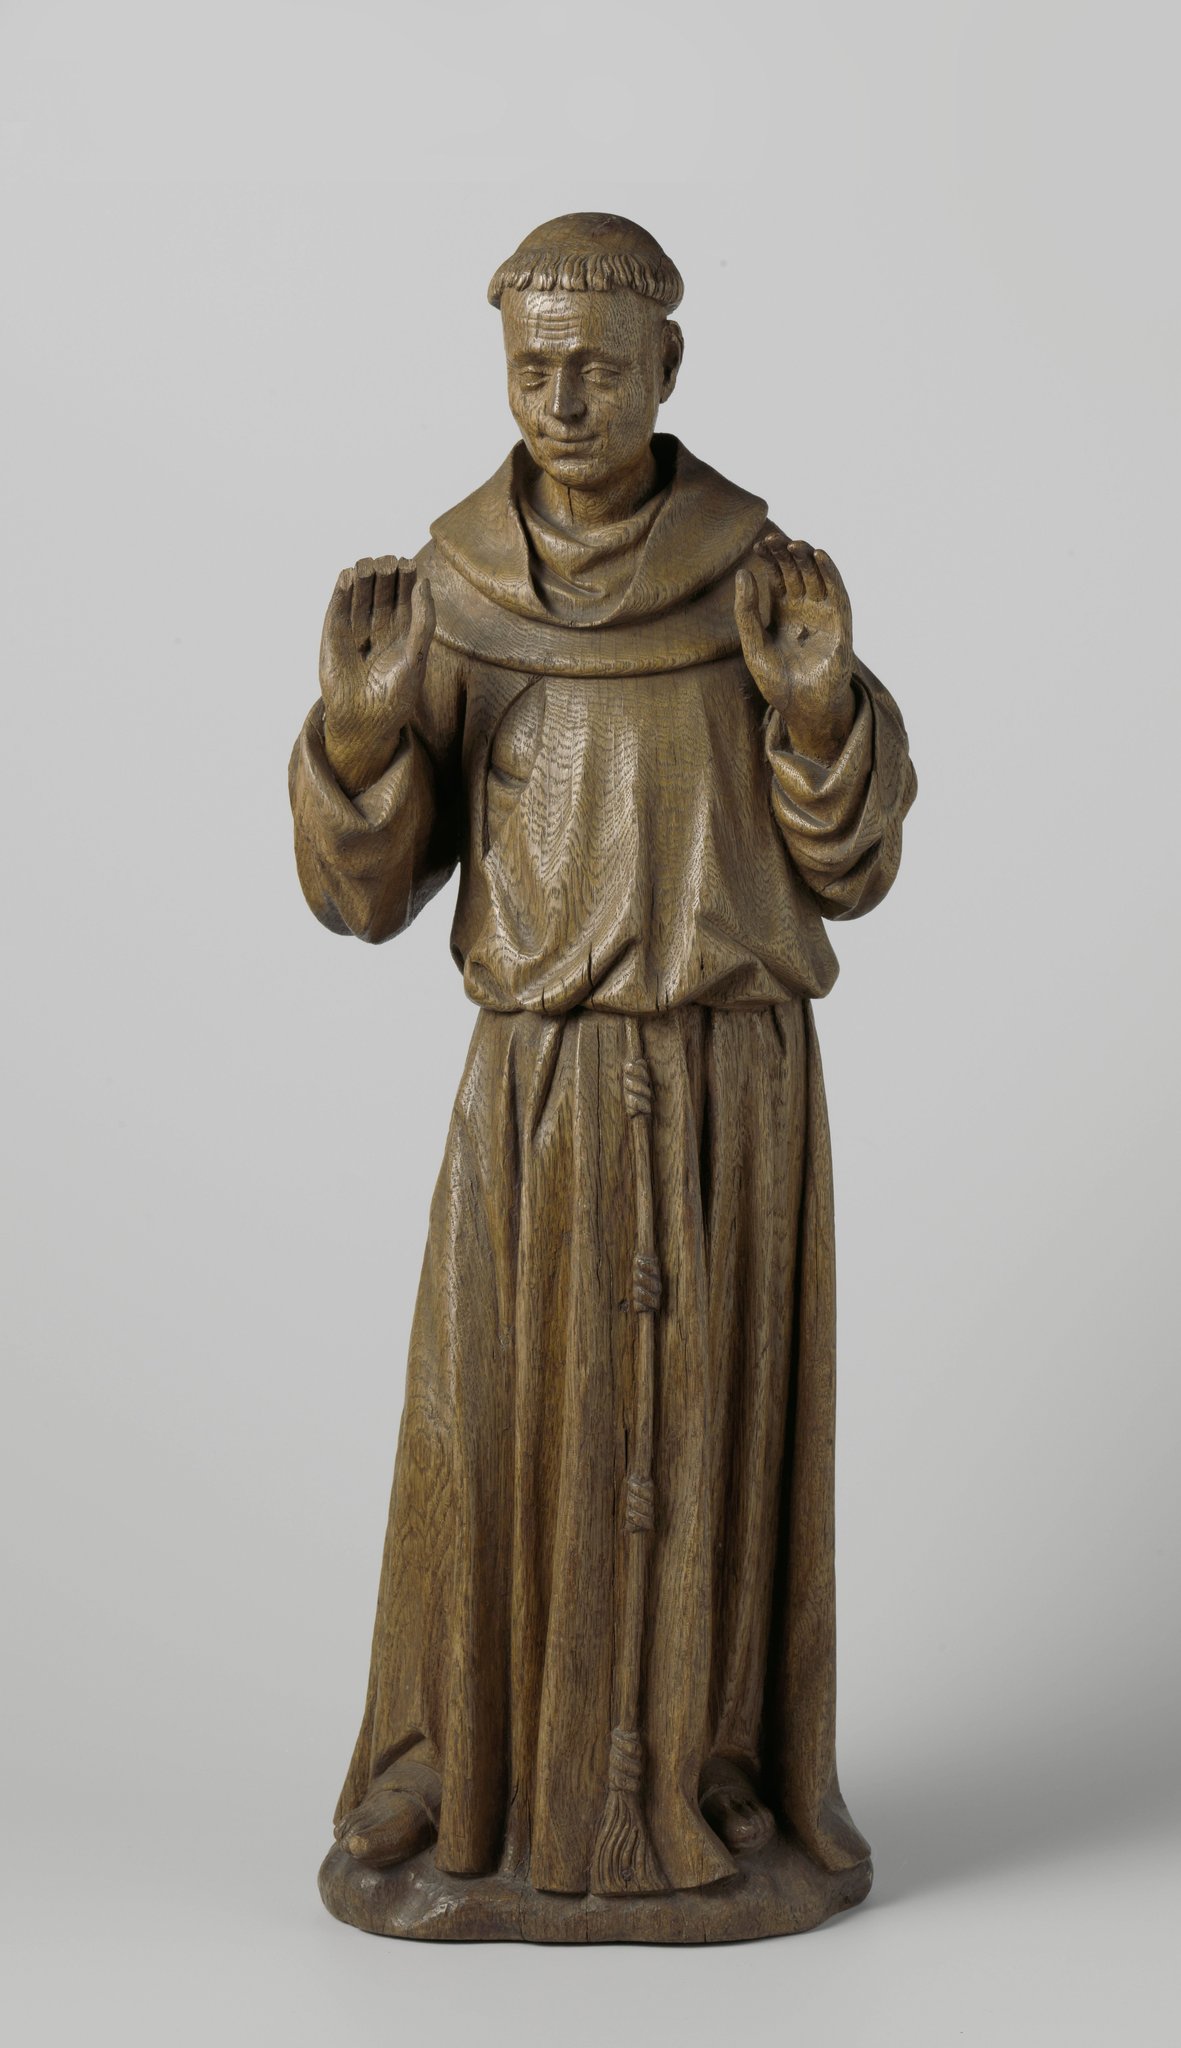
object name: sculpture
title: St Francis of Assisi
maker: Anonymous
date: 1550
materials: wood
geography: northern netherlands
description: Hij staat op een grondje en houdt de binnenzijden van zijn gestigmatiseerde handen op. Hij heeft tonsuur en glimlacht enigszins. Hij draagt een pij, waarvan de mouwen zijn teruggeslagen, en een gordel. Stigmata in de zijde en op een van de in sandalen gestoken voeten.